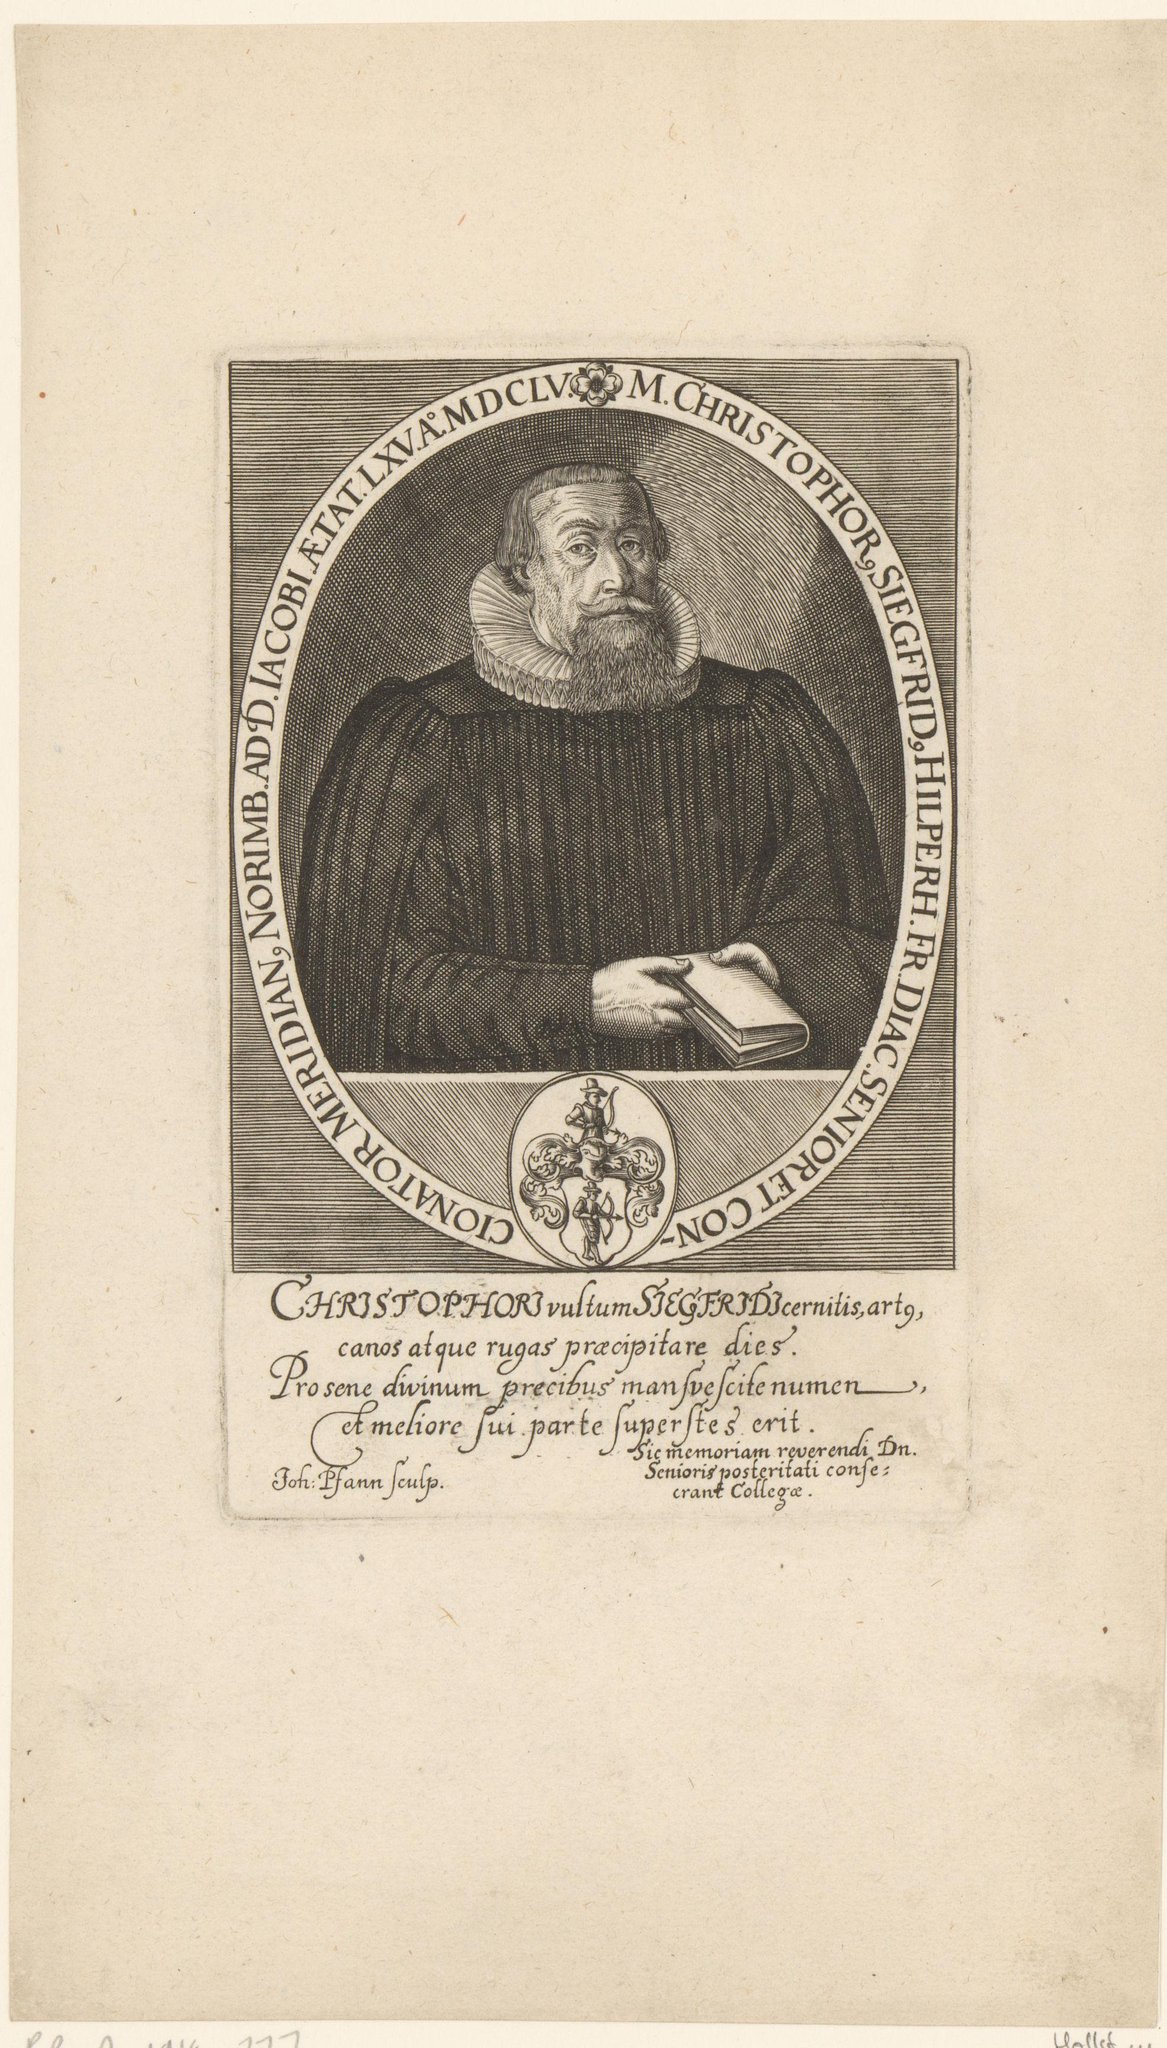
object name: print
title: Portret van Christoph Siegfried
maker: johann pfann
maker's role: print maker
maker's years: 1640-1680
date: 1648-1663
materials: paper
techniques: engraving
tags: historical persons, book, armorial bearing, heraldry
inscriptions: collector's mark: Lugt 2228